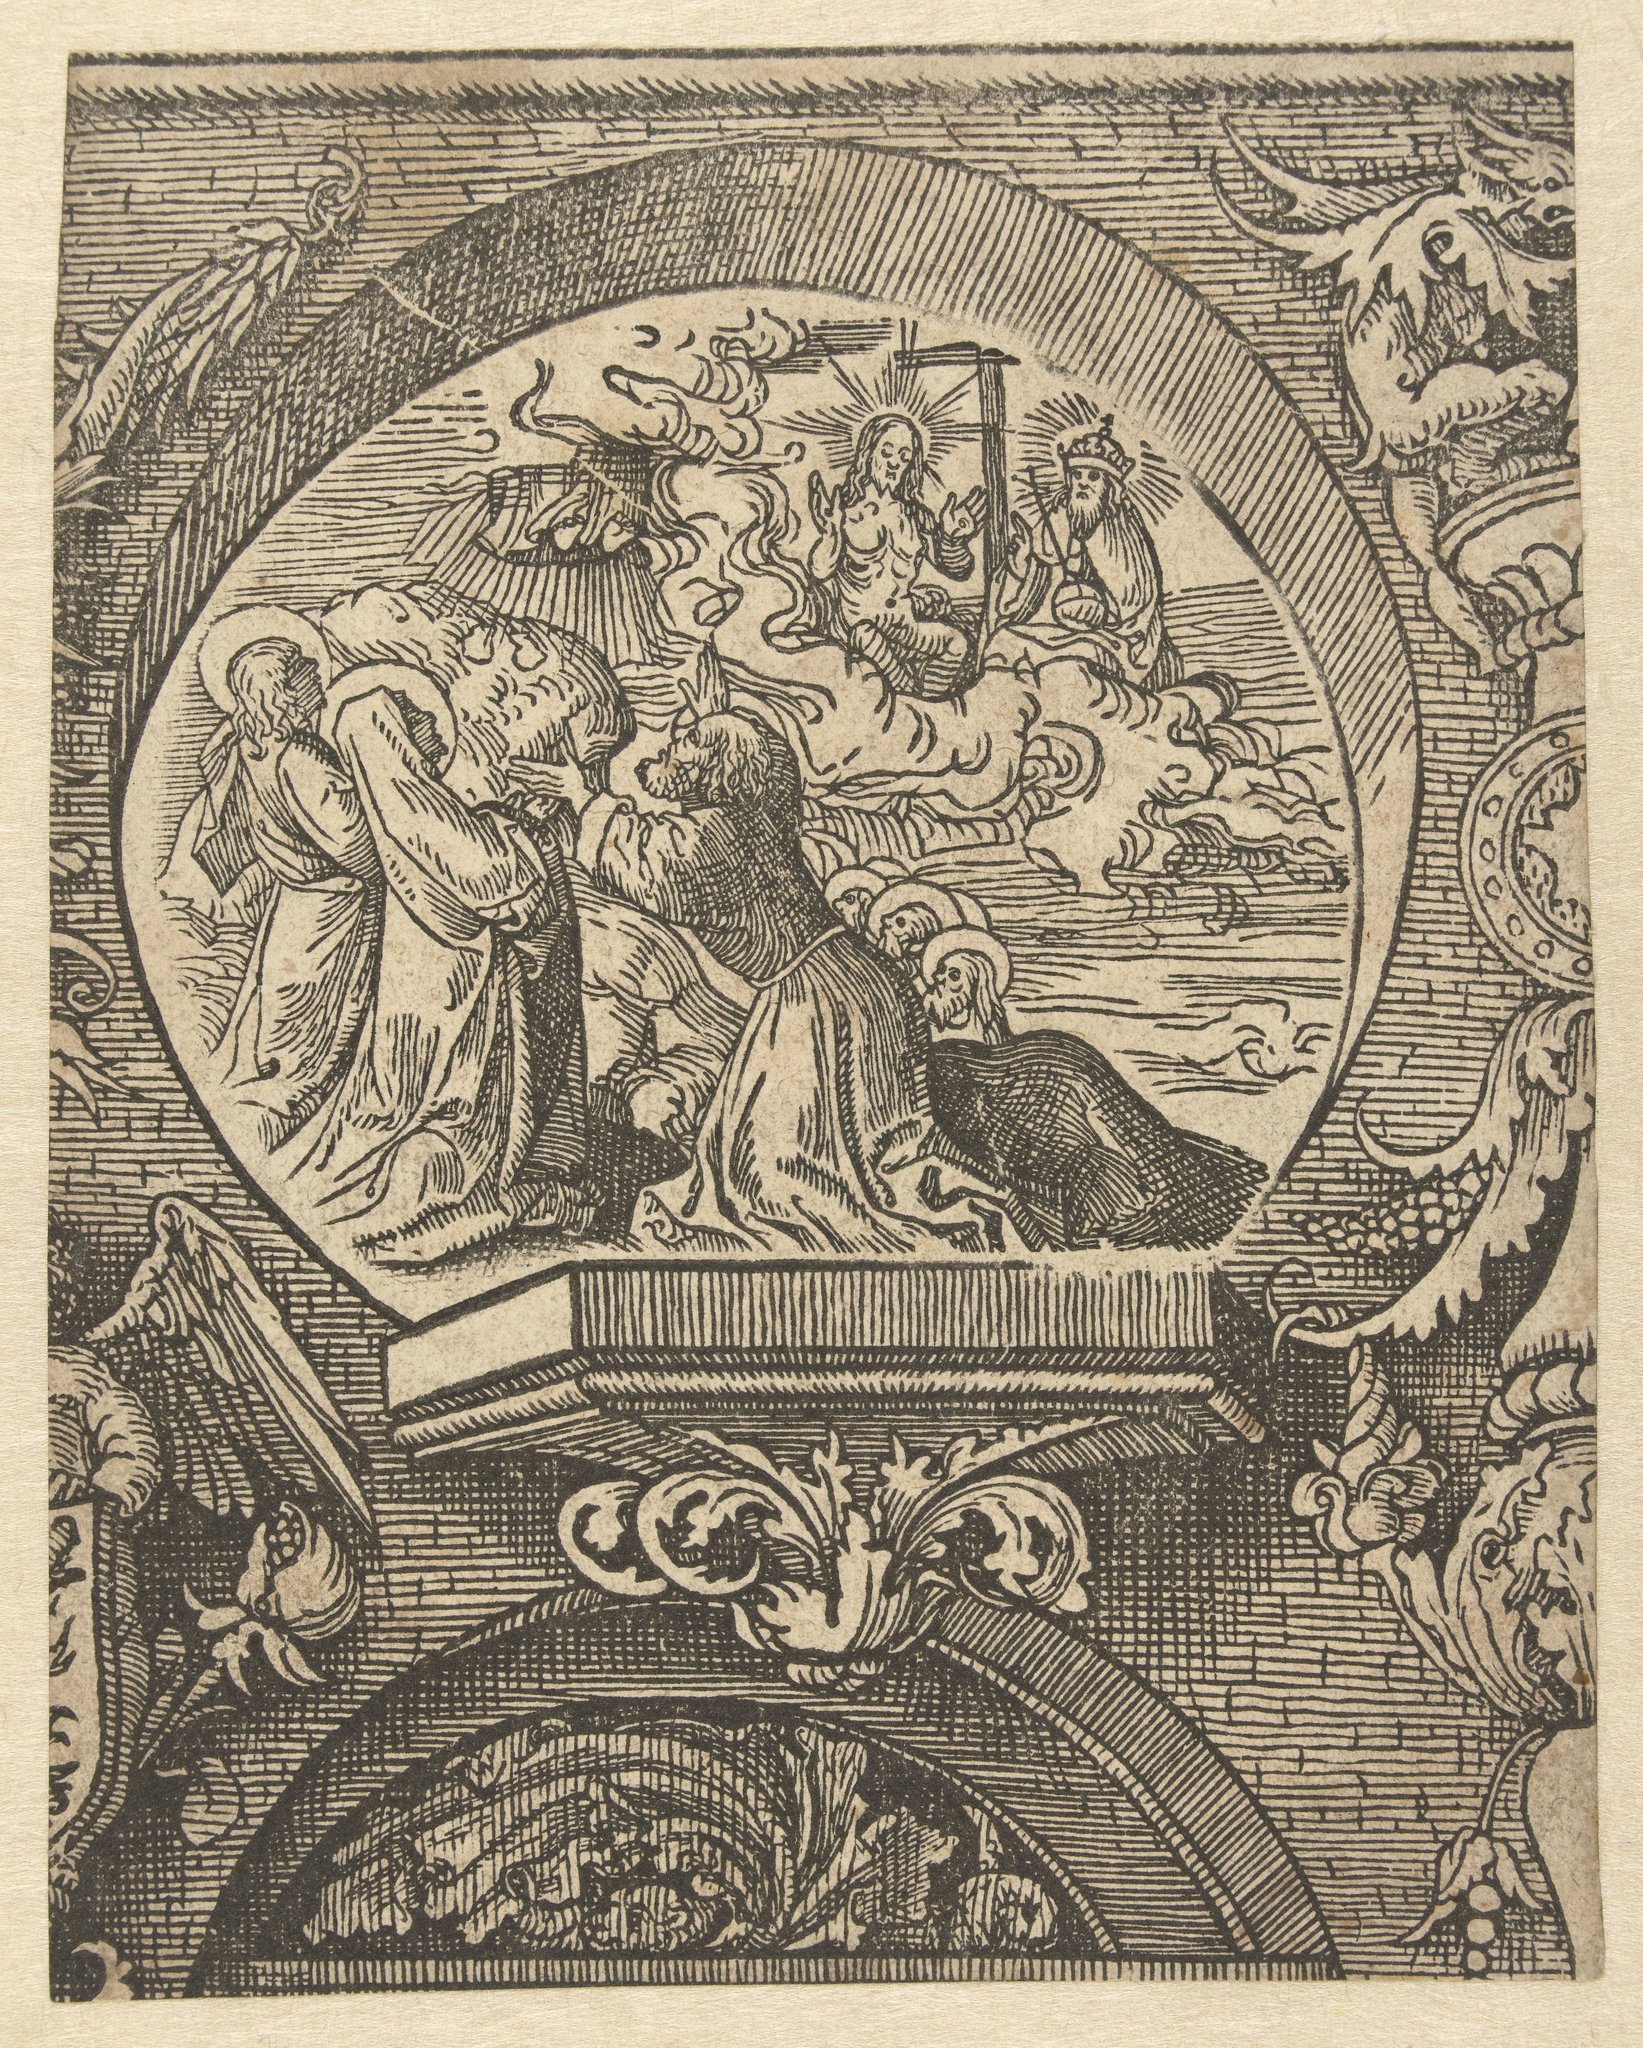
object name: print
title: De hemelvaart en Christus voor God de Vader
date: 1520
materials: paper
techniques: woodcut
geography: amsterdam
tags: the ascension (christ surrounded by radiant light or in a mandorla), 'ascendit ad coelos, sedet ad dexteram patris omnipotentis' ~ articles of faith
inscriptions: collector's mark: Lugt 240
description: Gedrukt van twee blokken. Ornamentele omlijsting rond voorstelling met Maria, Johannes en apostelen omhoog kijkend naar Christus waarvan alleen voeten en mantel zichtbaar. Op een wolk Christus met gespreide handen voor God de Vader, kruis tussen hen.